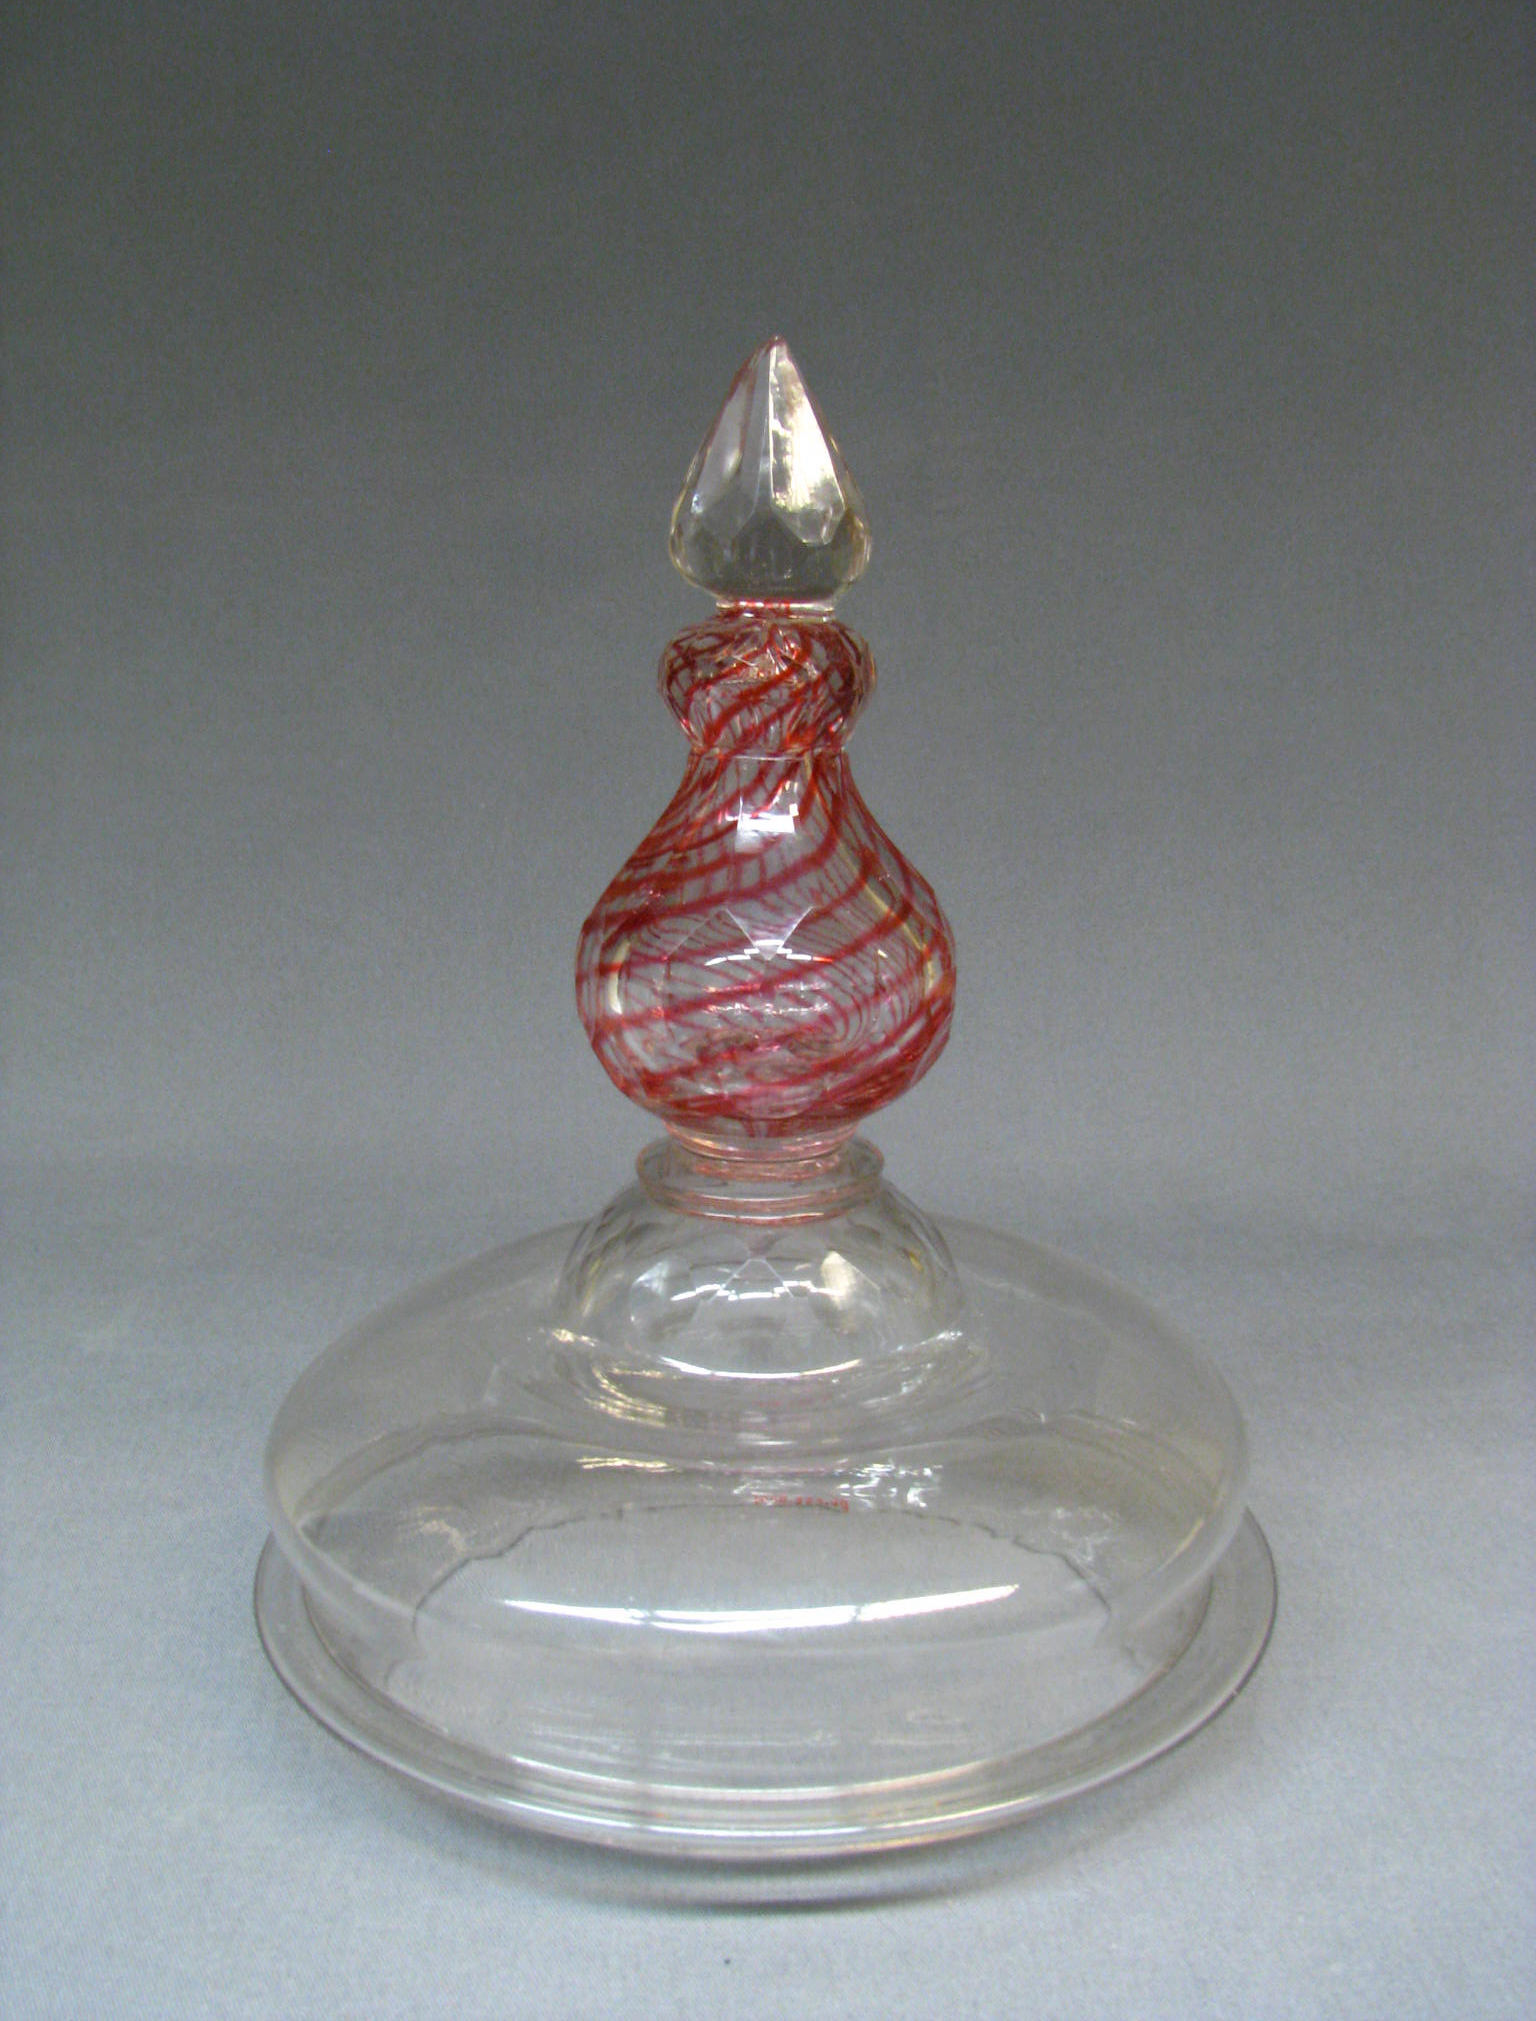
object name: standing cup with cover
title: Standing cup cover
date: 1830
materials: glass